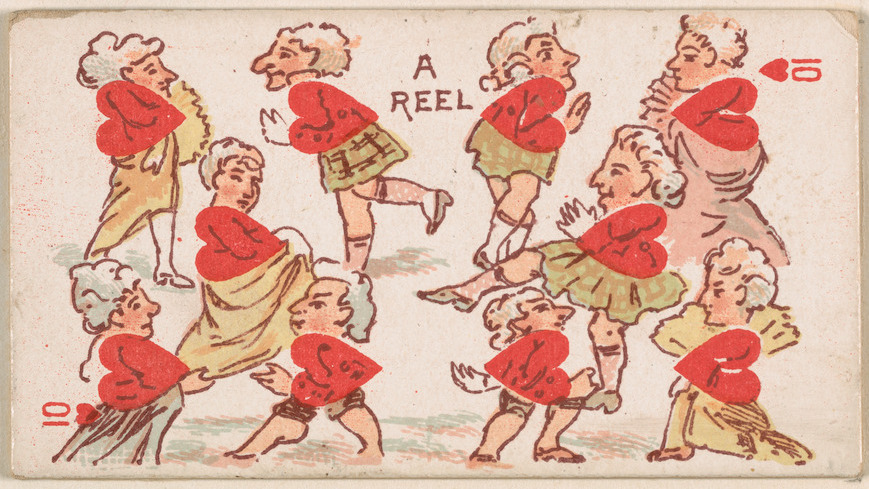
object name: print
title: Ten of Hearts, A Reel, from Harlequin Cards, 2nd Series (N220) issued by Kinney Bros.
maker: kinney brothers tobacco company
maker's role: publisher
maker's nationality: american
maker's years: 1869-2011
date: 1889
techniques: color lithograph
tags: playing cards